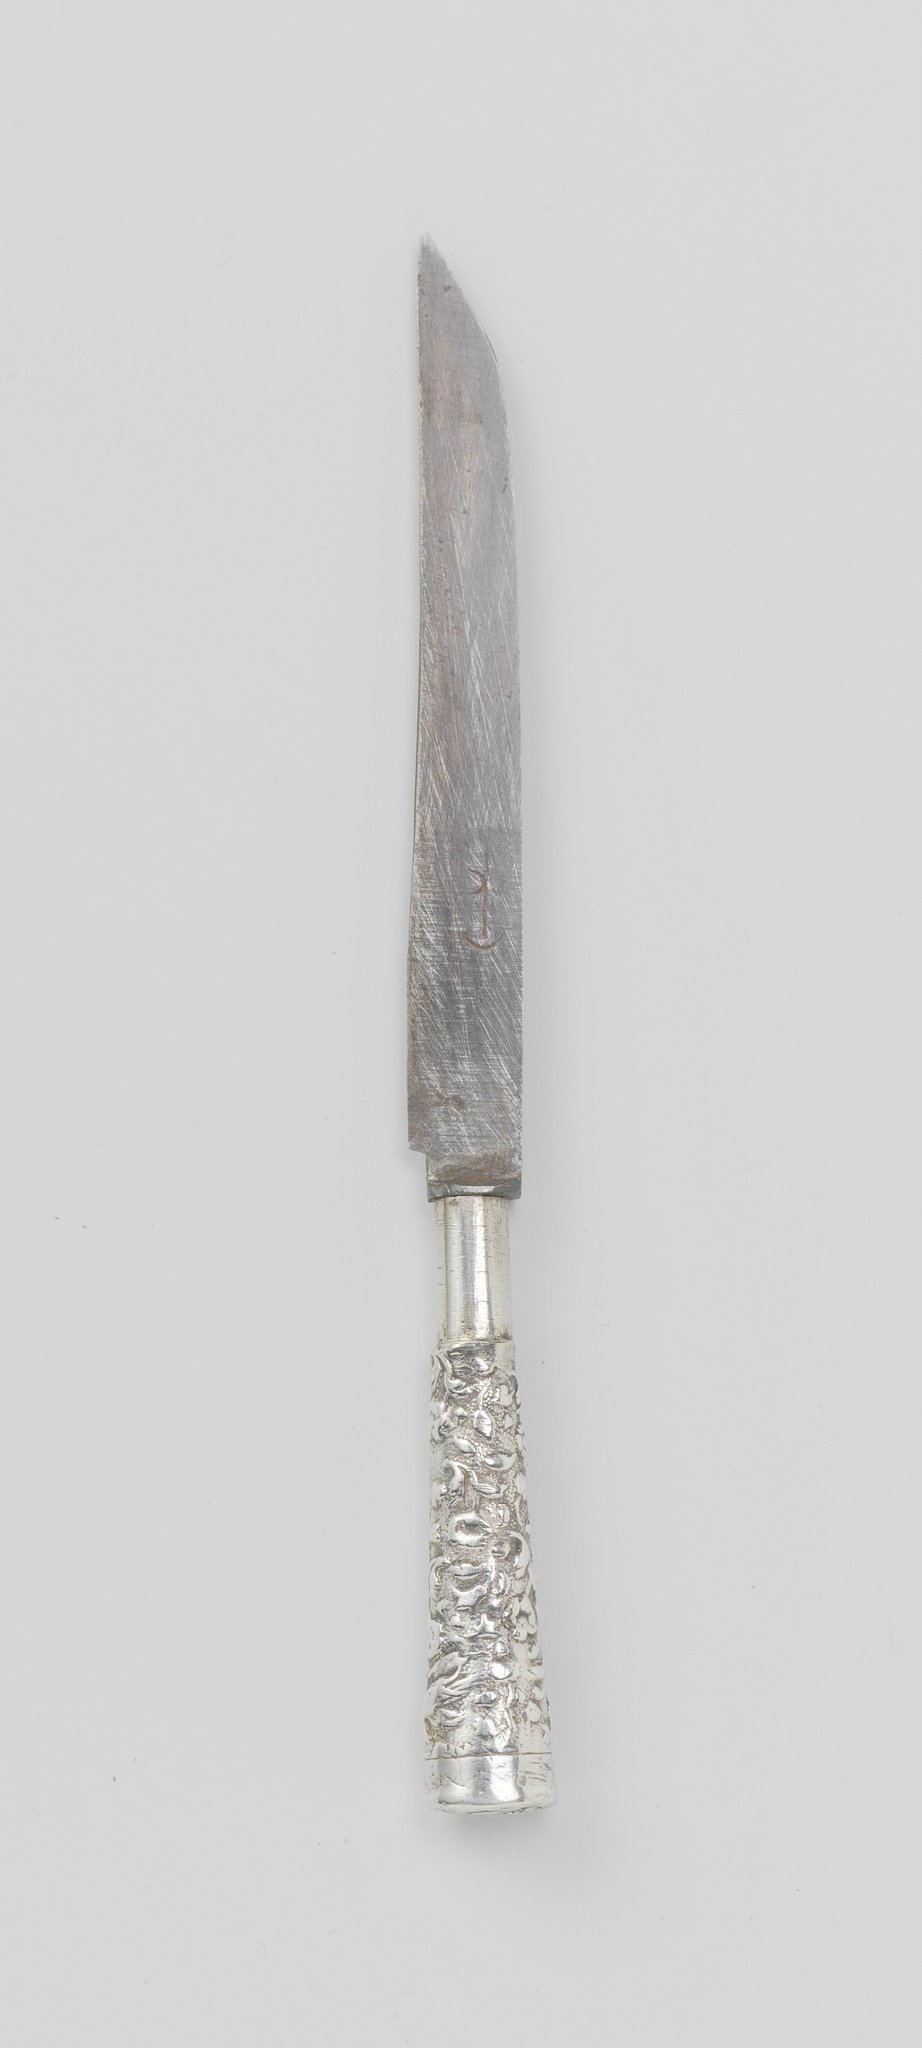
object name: reisbestek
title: Mes met heft voorzien van fijne reliëfranken op gegranuleerde grond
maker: Anonymous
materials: silver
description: Mes met heft van zilver. Het messenheft is voorzien van fijne reliefranken op gegranuleerde grond. Lemmet van het mes is gemerkt, ingegrift met II T.H.